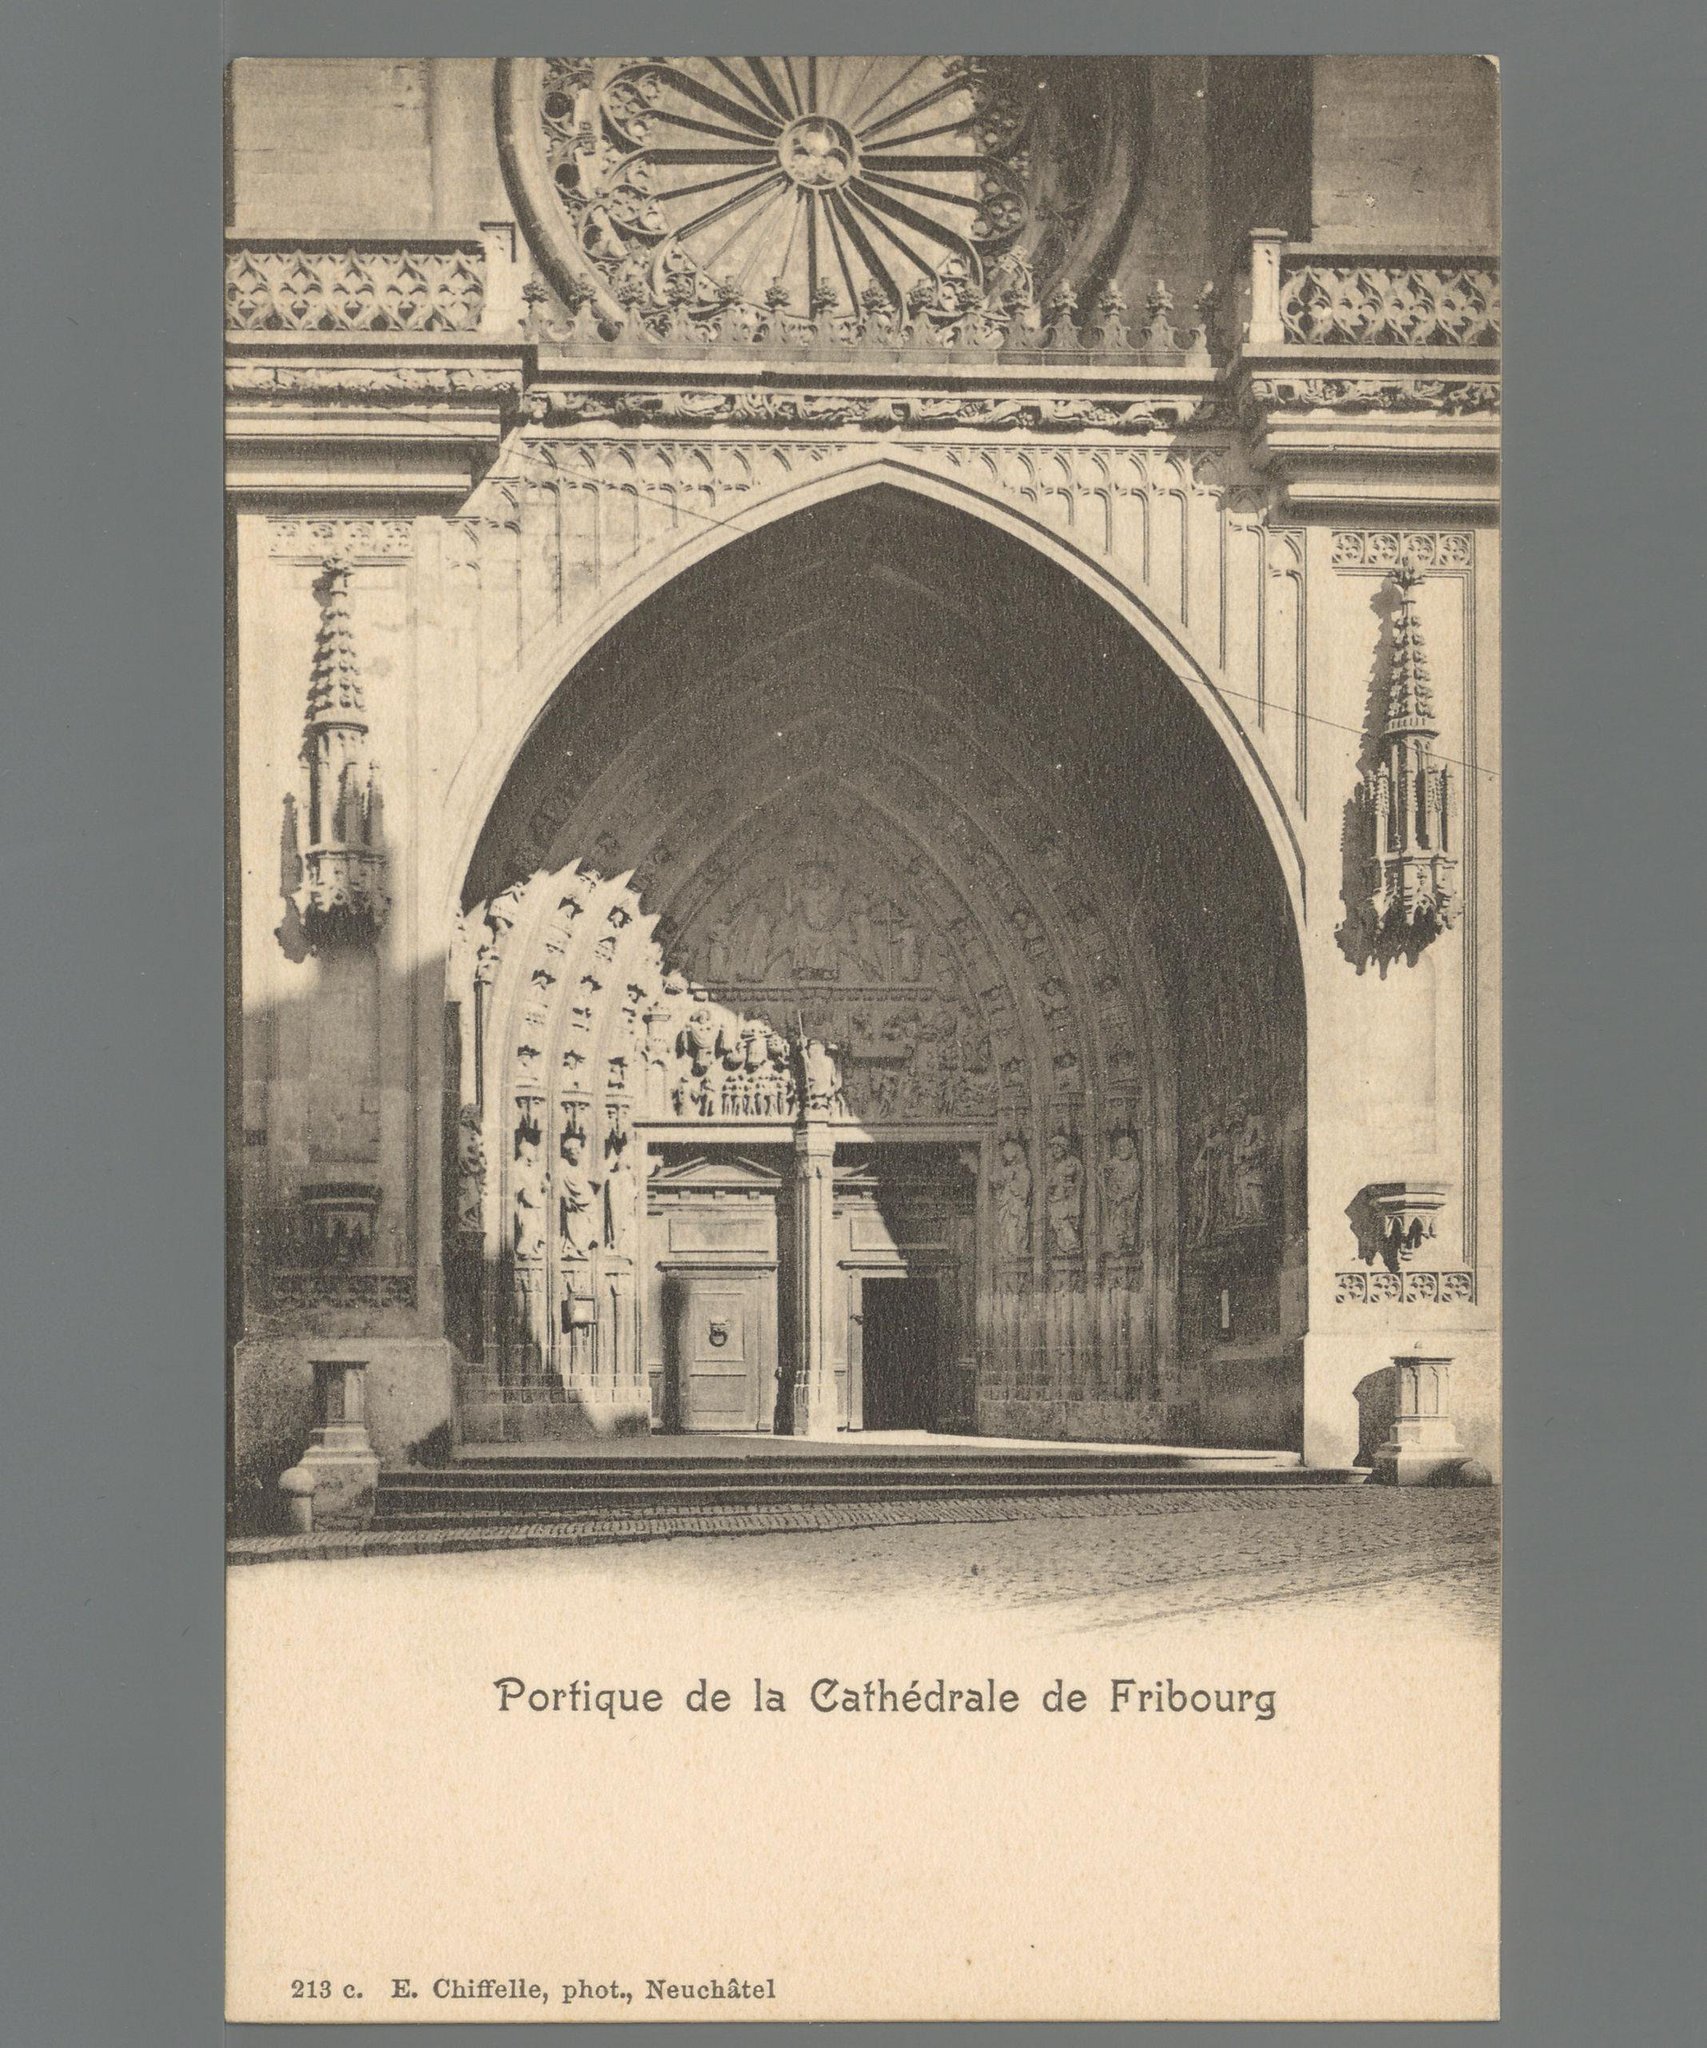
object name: ansichtkaart, prentbriefkaart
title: Portique de la Cathédrale de Fribourg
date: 1903-1905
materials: cardboard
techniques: photograph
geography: fribourg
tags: parts of church exterior and annexes: portal